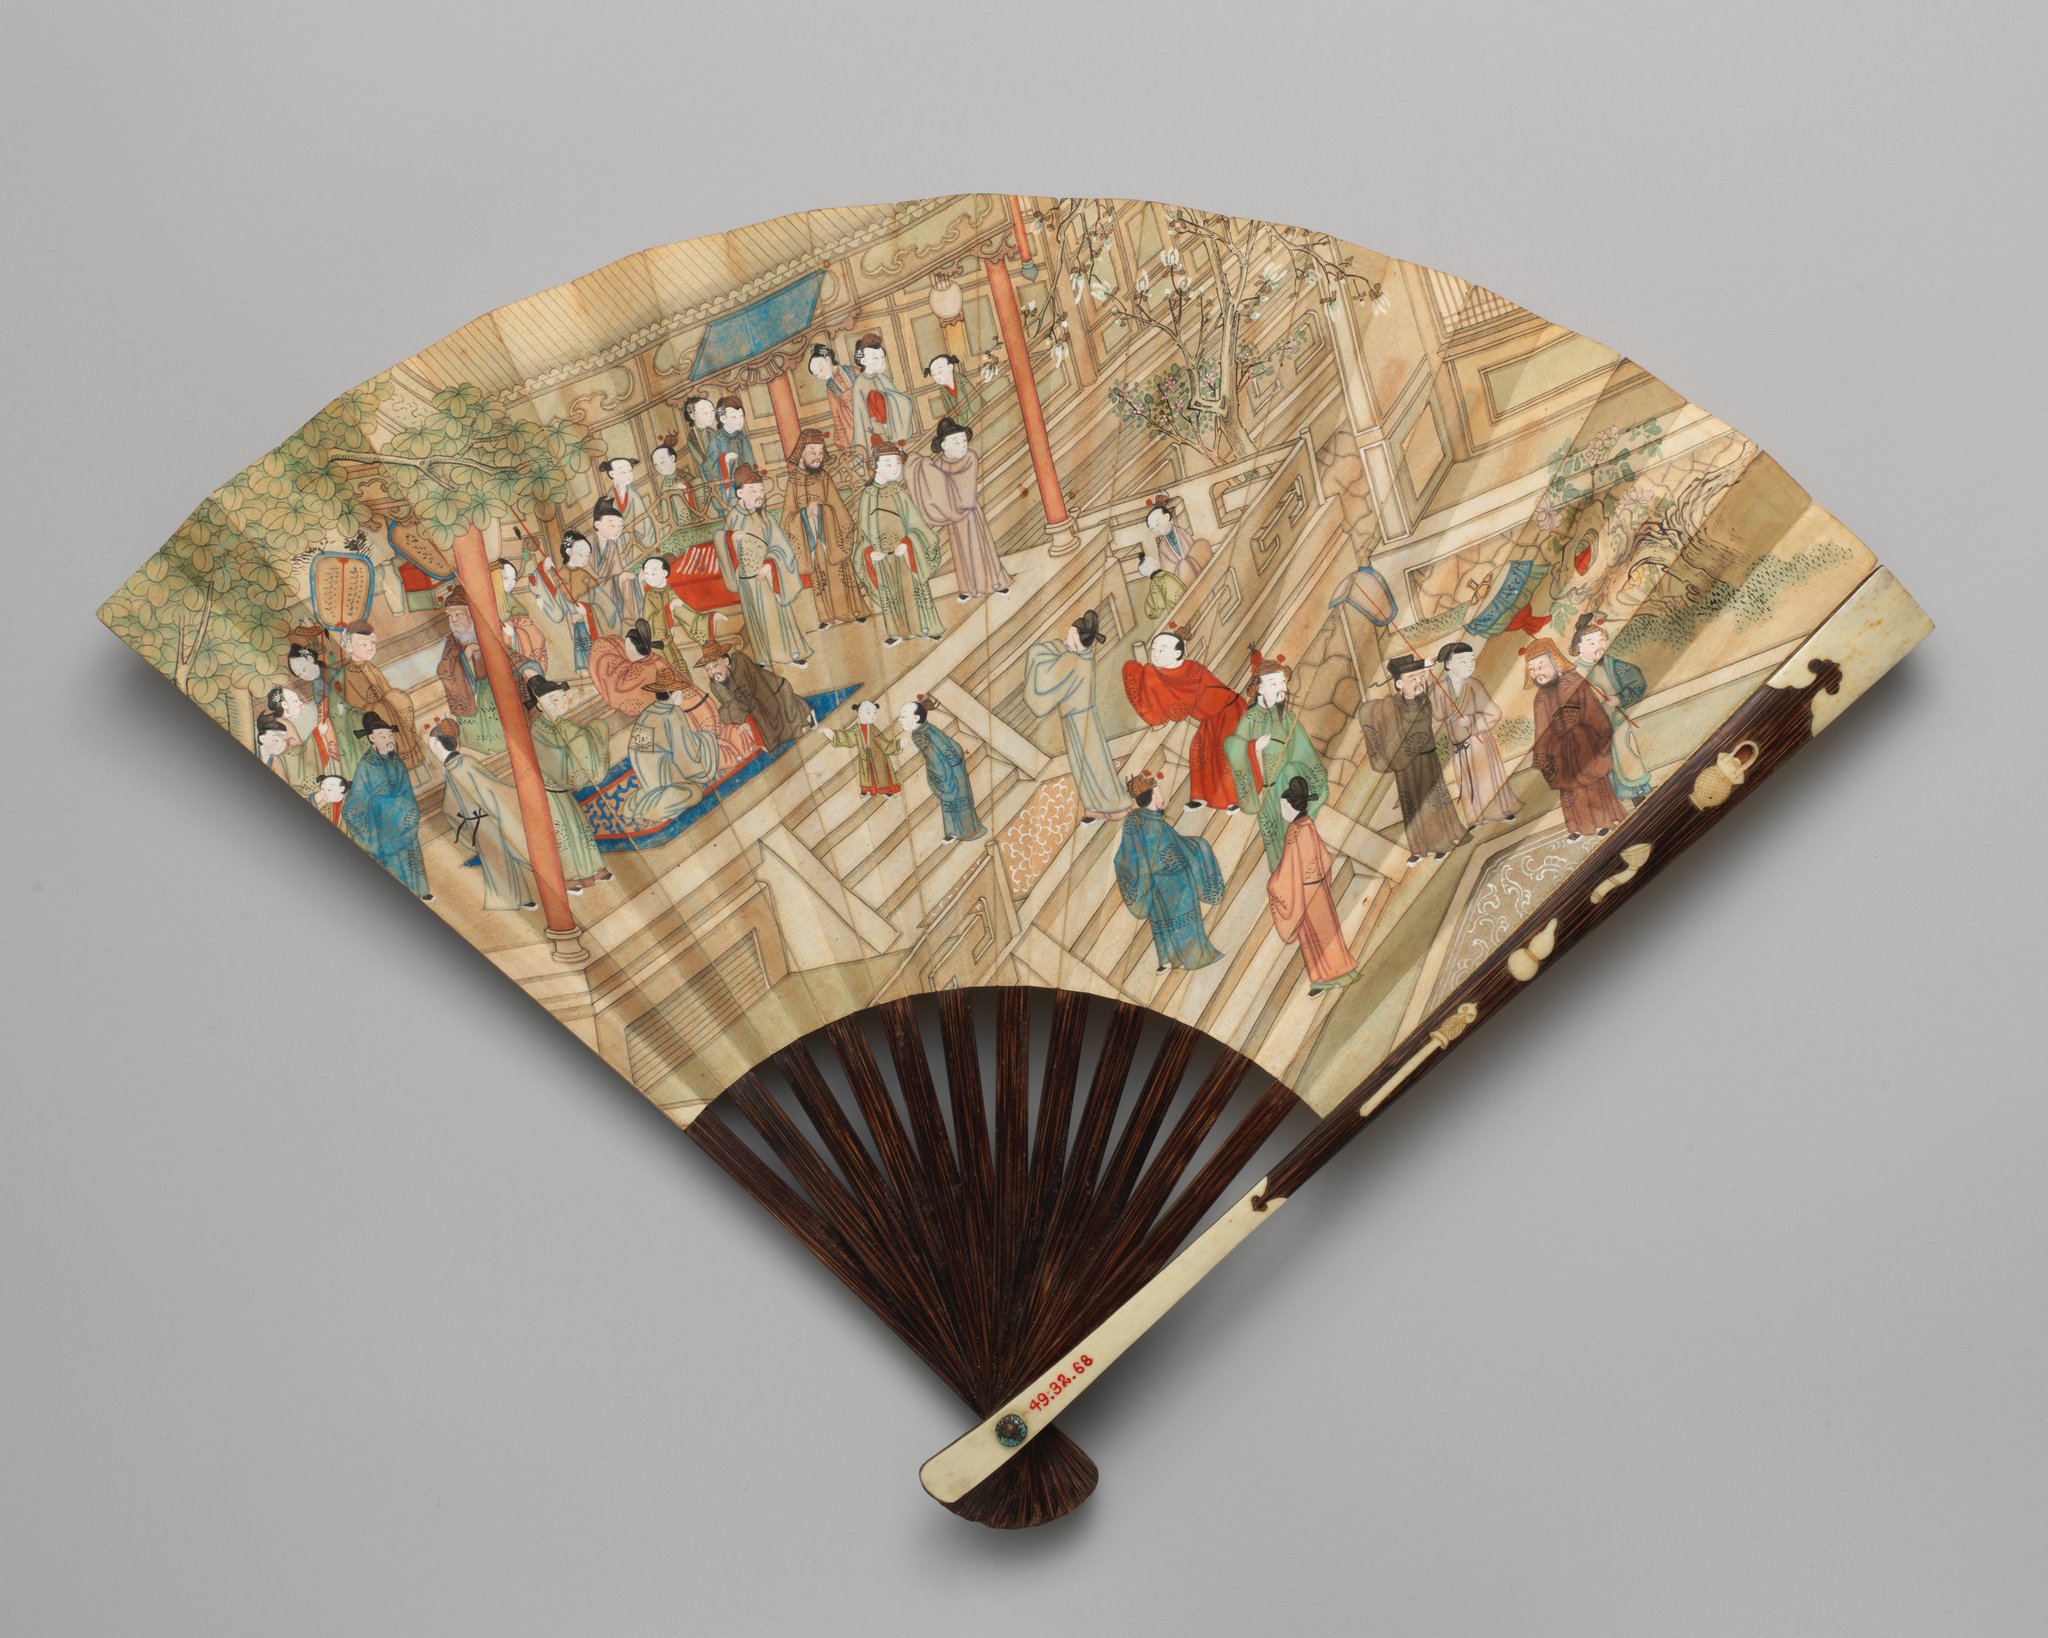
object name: fan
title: Folding Fan with Scene of an Audience with an Emperor and Empress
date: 1767-1833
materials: brass, ivory, paper, wood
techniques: hand coloring, printing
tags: temples,men,women